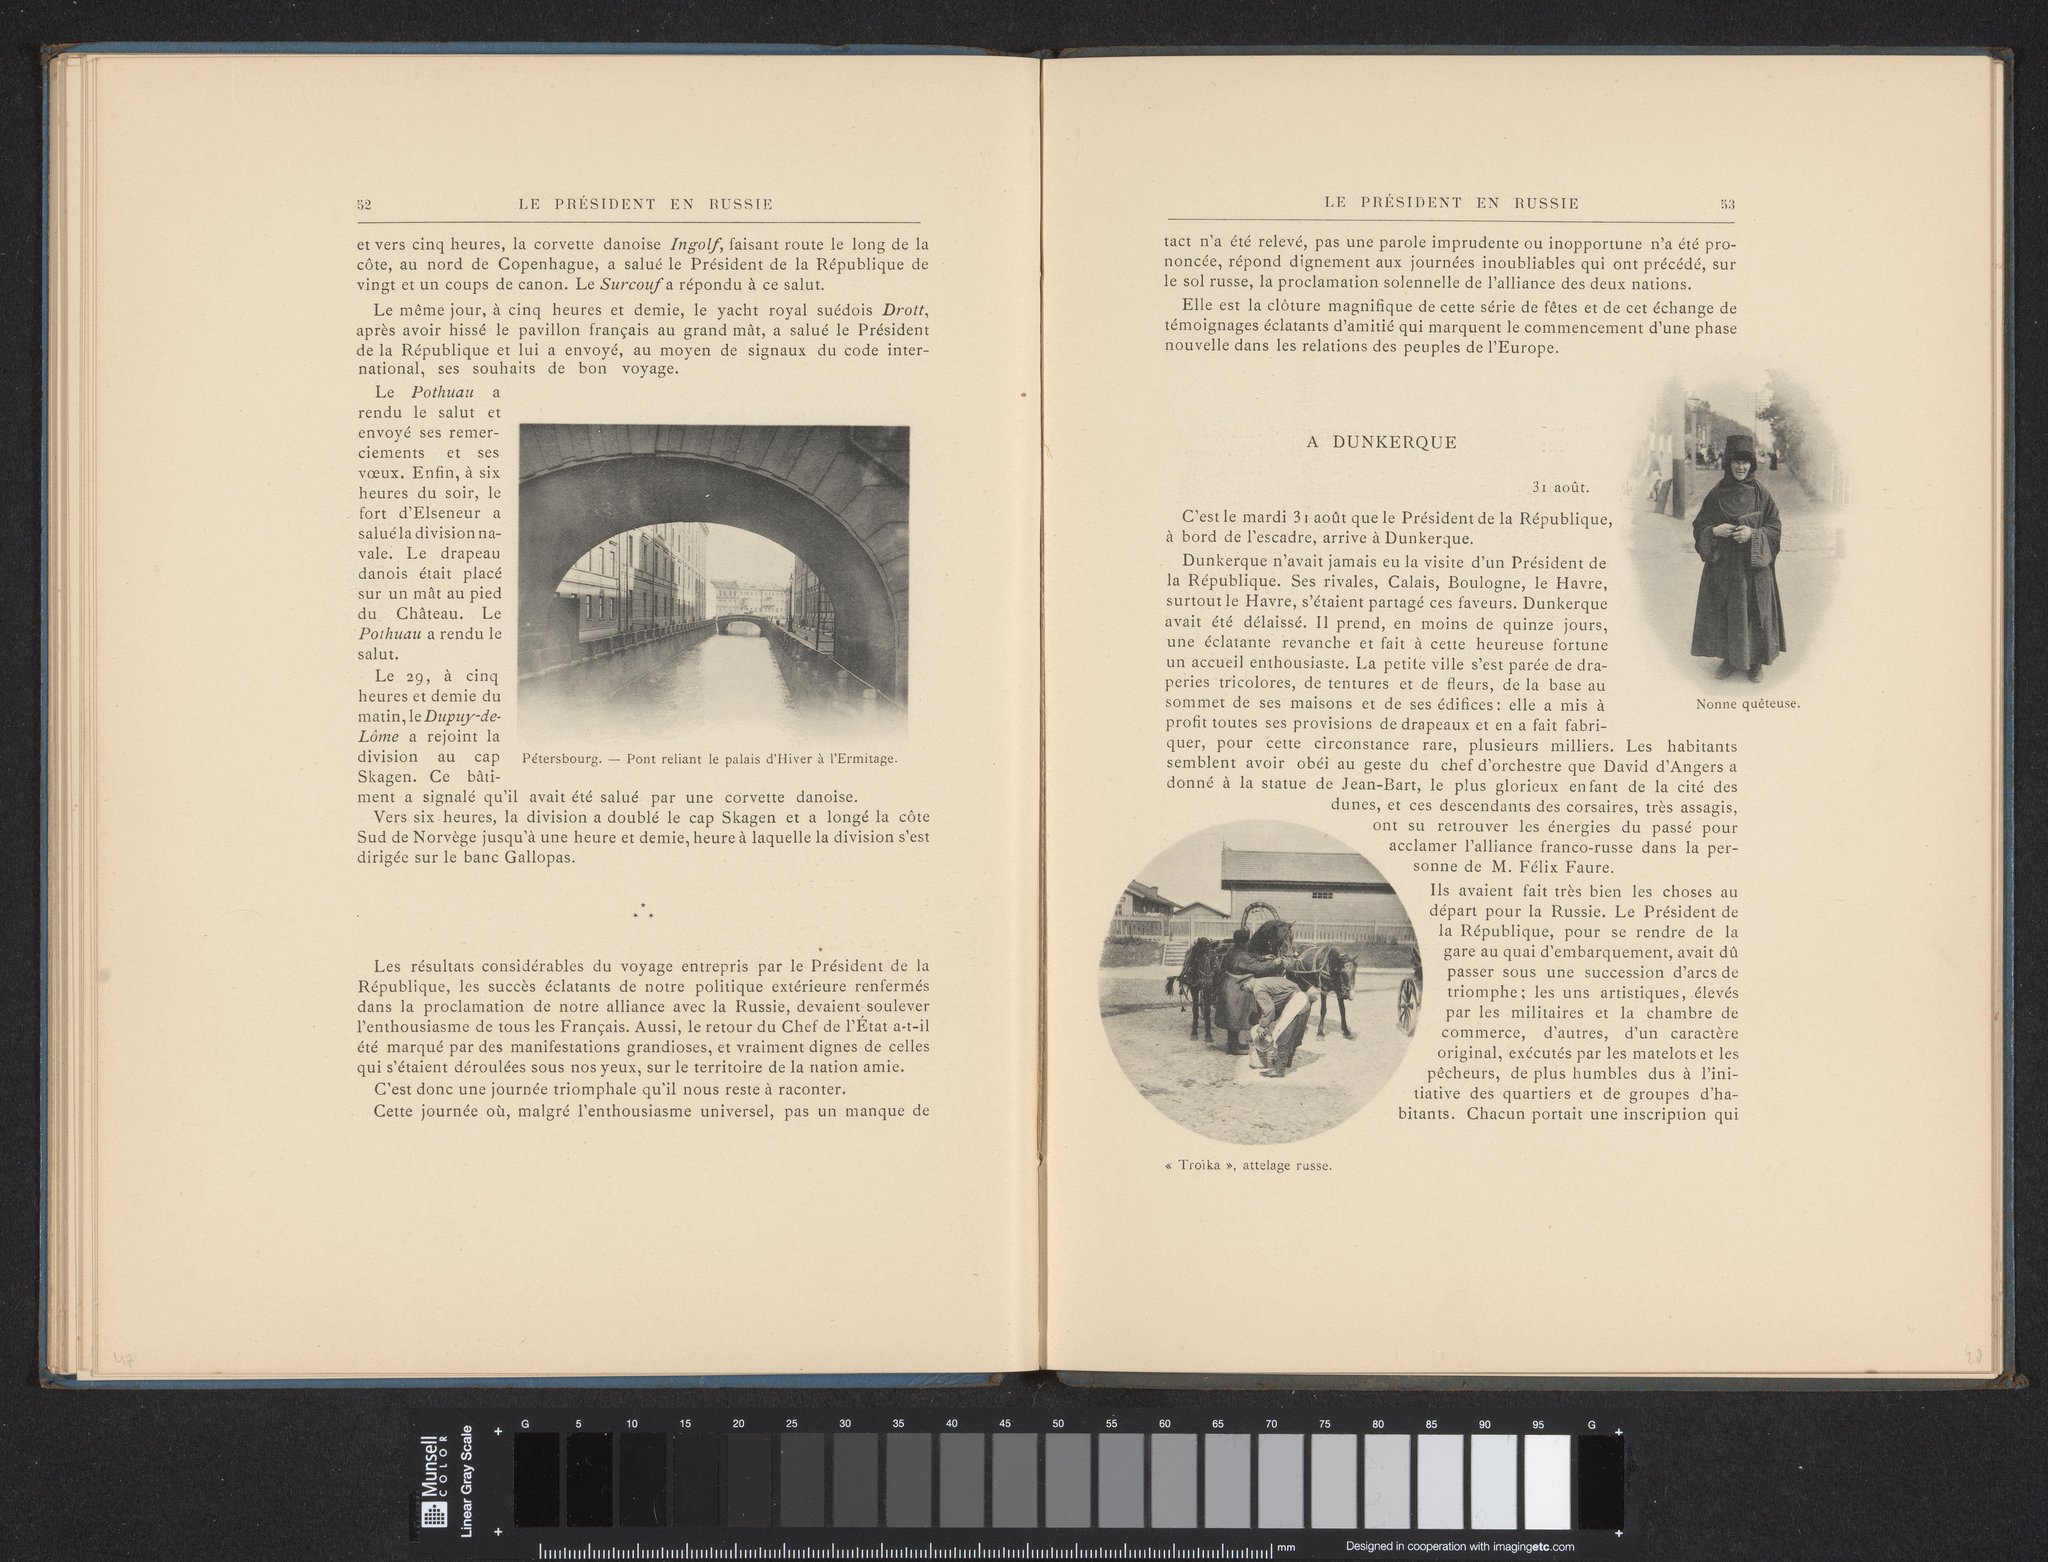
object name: page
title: Gezicht op een brug van de Hermitage te Sint-Petersburg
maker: Anonymous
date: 1897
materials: paper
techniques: photograph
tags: palace, bridge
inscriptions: inscription: ‘Pétersbourg.- Pont reliant le palais d'Hiver à l'Ermitage.’